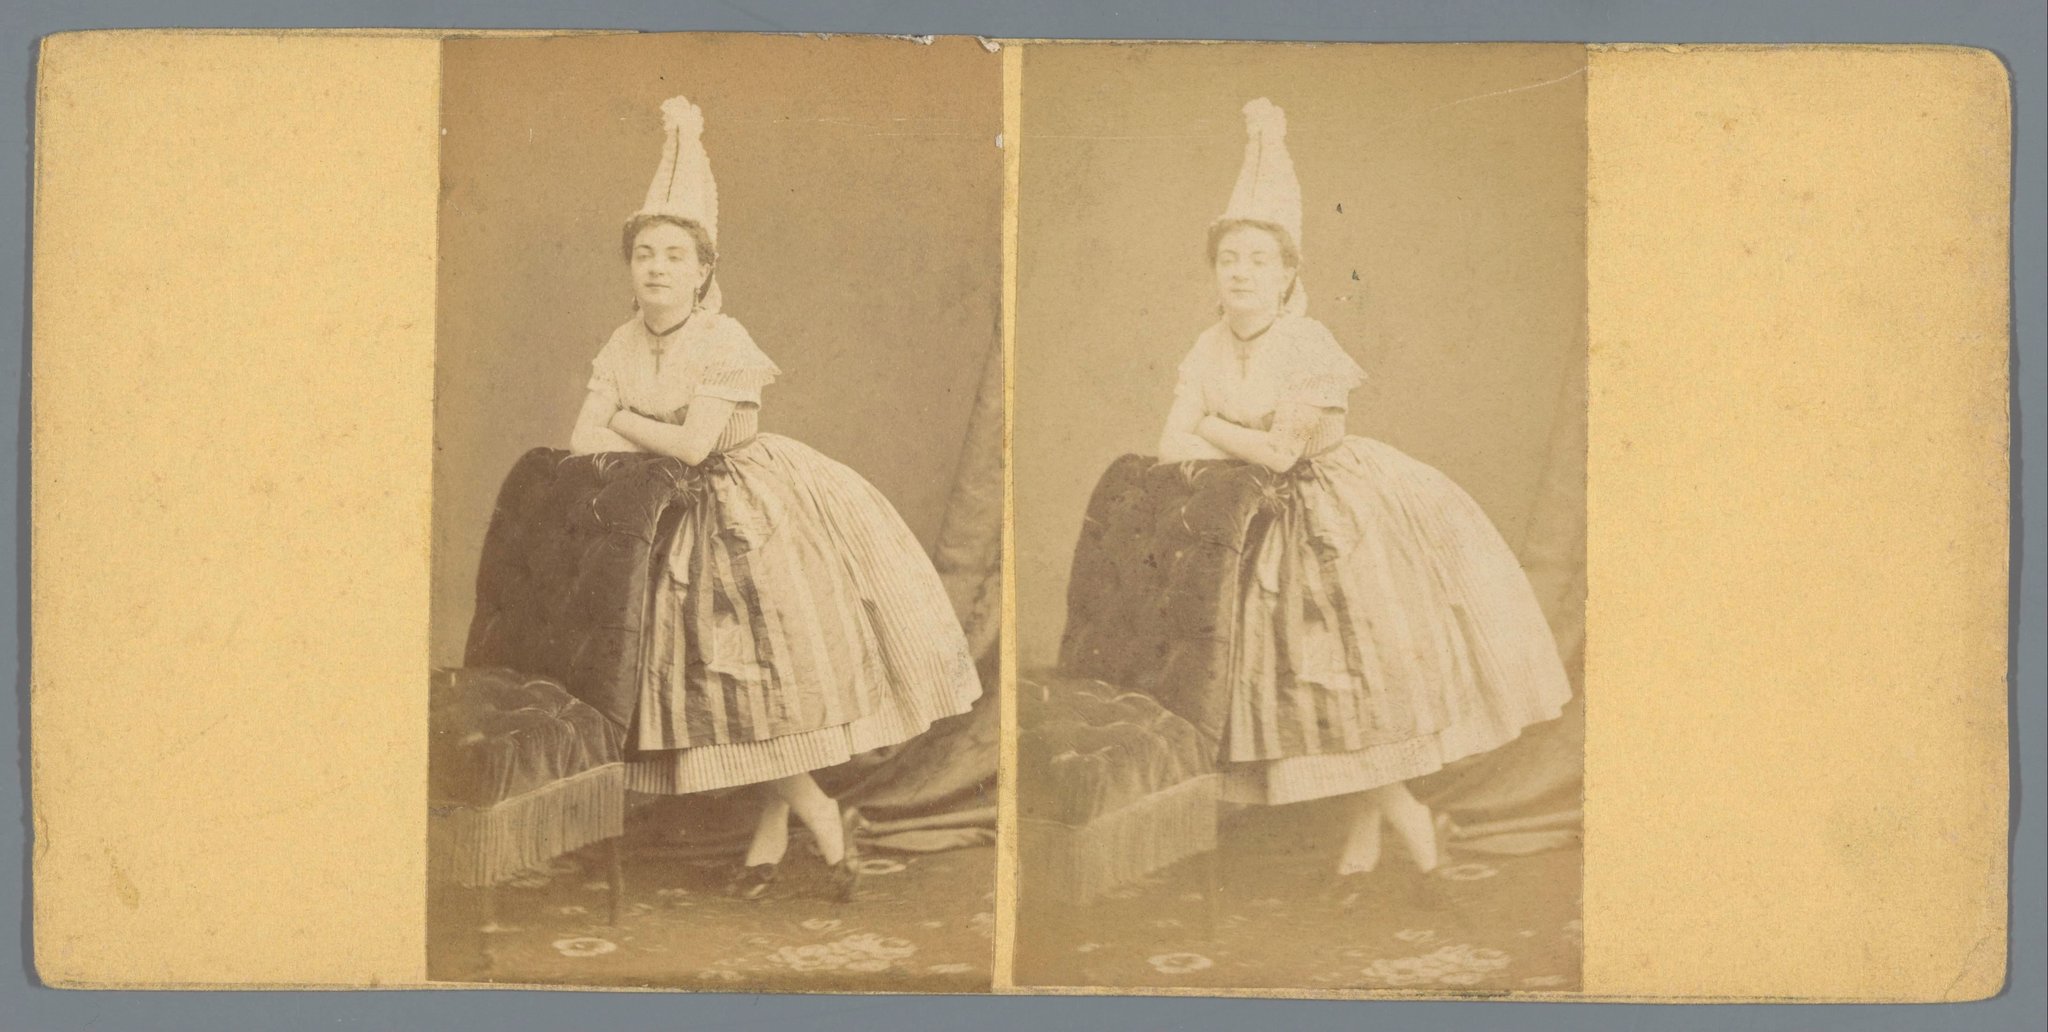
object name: stereograph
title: Portret van een vrouw in een jurk en met een hoge muts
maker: Anonymous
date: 1850-1880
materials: cardboard, photographic support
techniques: albumen print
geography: europe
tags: head-gear: cap, clothes, costume, europe